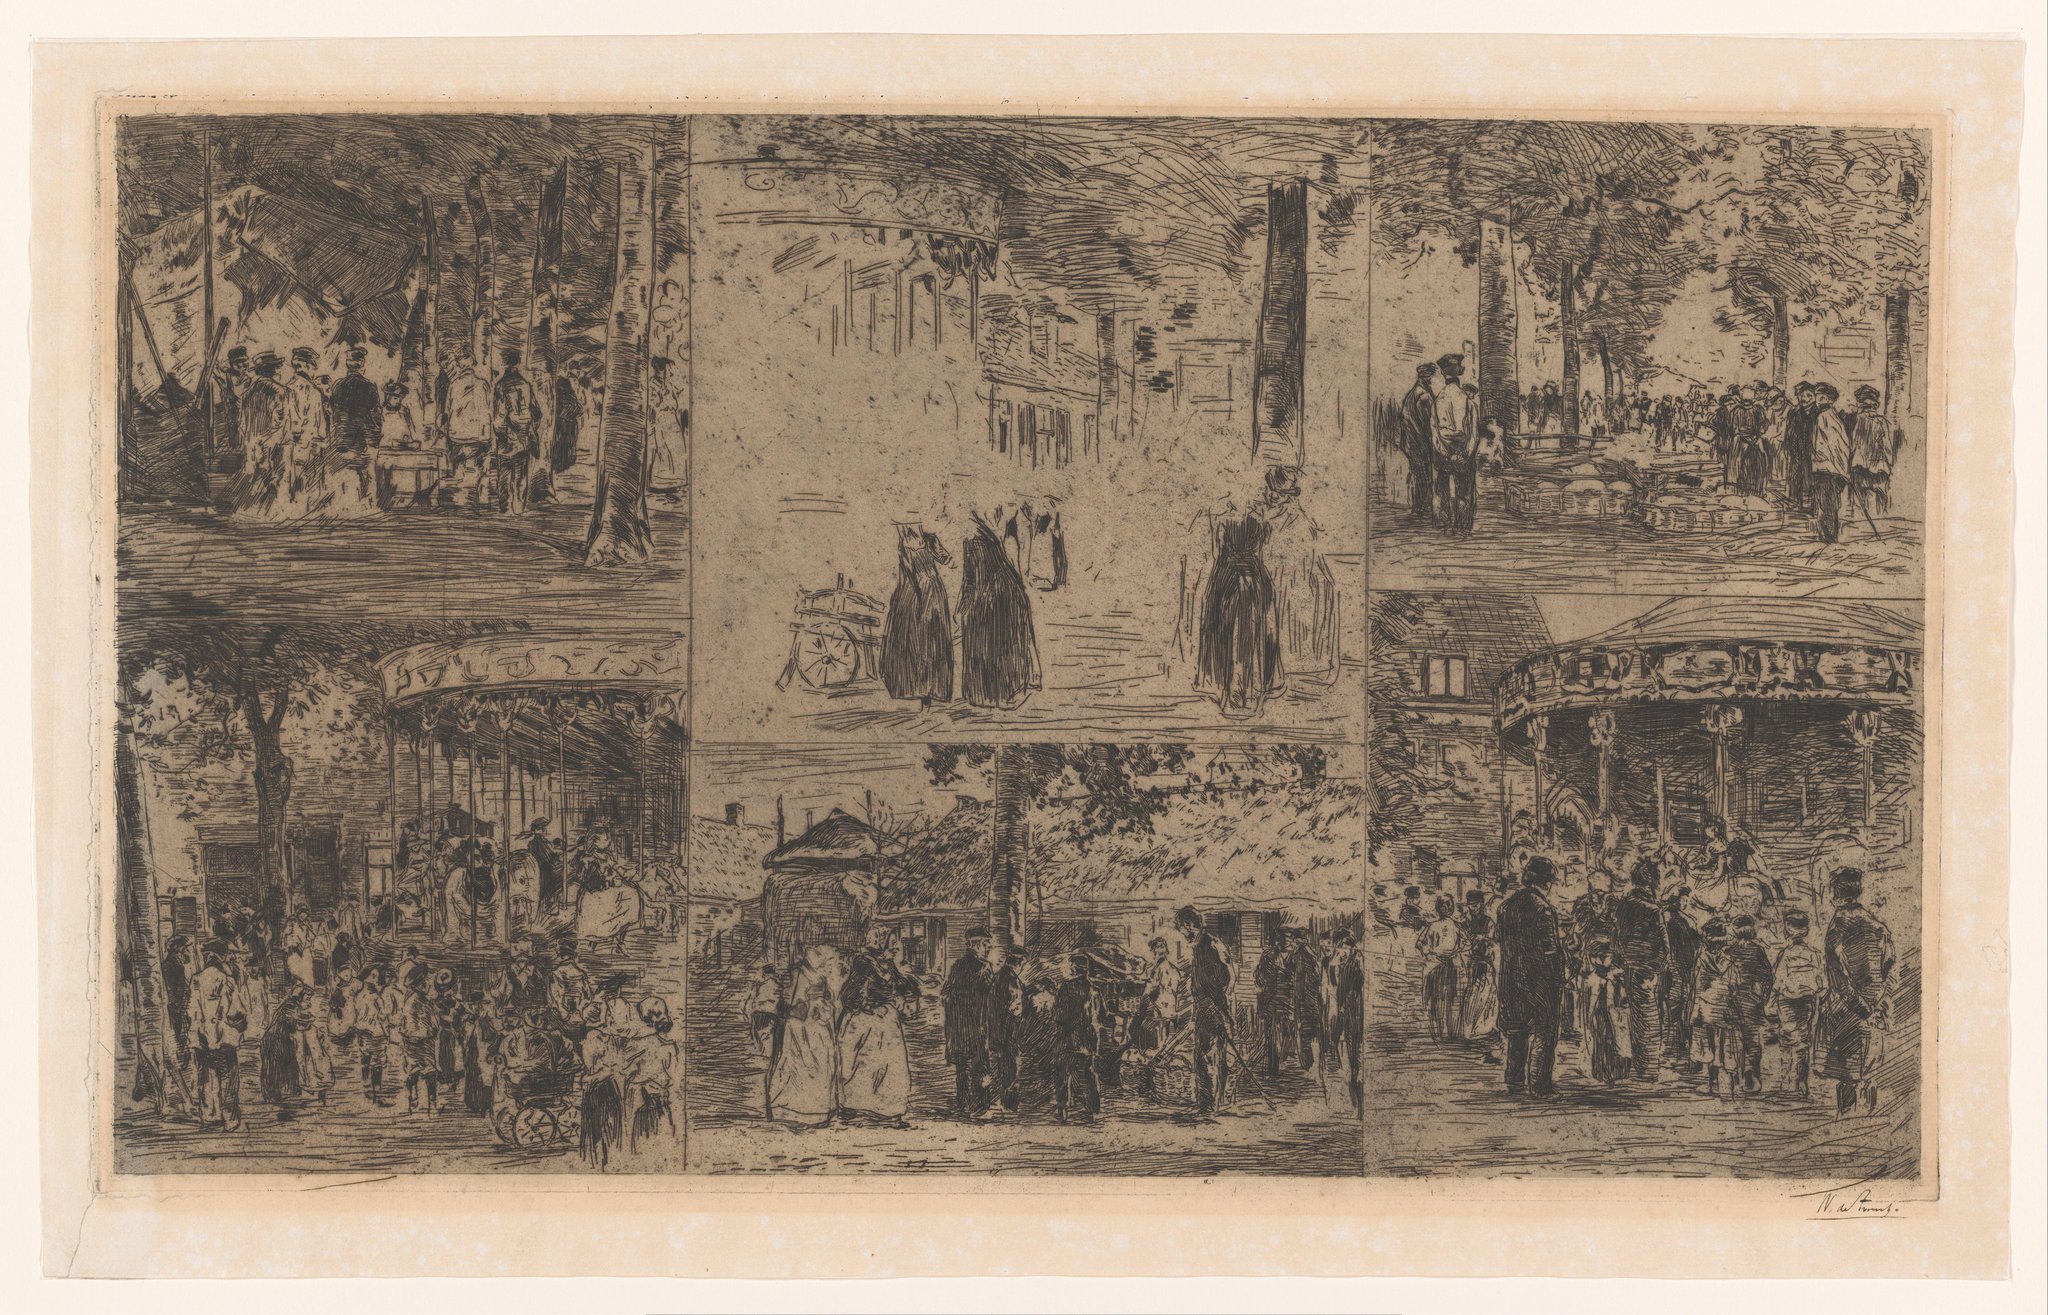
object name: print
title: Zes schetsen van een marktdag en een dorpskermis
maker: willem de zwart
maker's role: draughtsman, painter, print maker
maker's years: 1862-1931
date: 1872-1931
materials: paper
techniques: etching, intaglio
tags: merry-go-round, roundabout; chair o'plane, farmers, public festivities, market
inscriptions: collector's mark: Lugt 2760, collector's mark: Lugt 2228